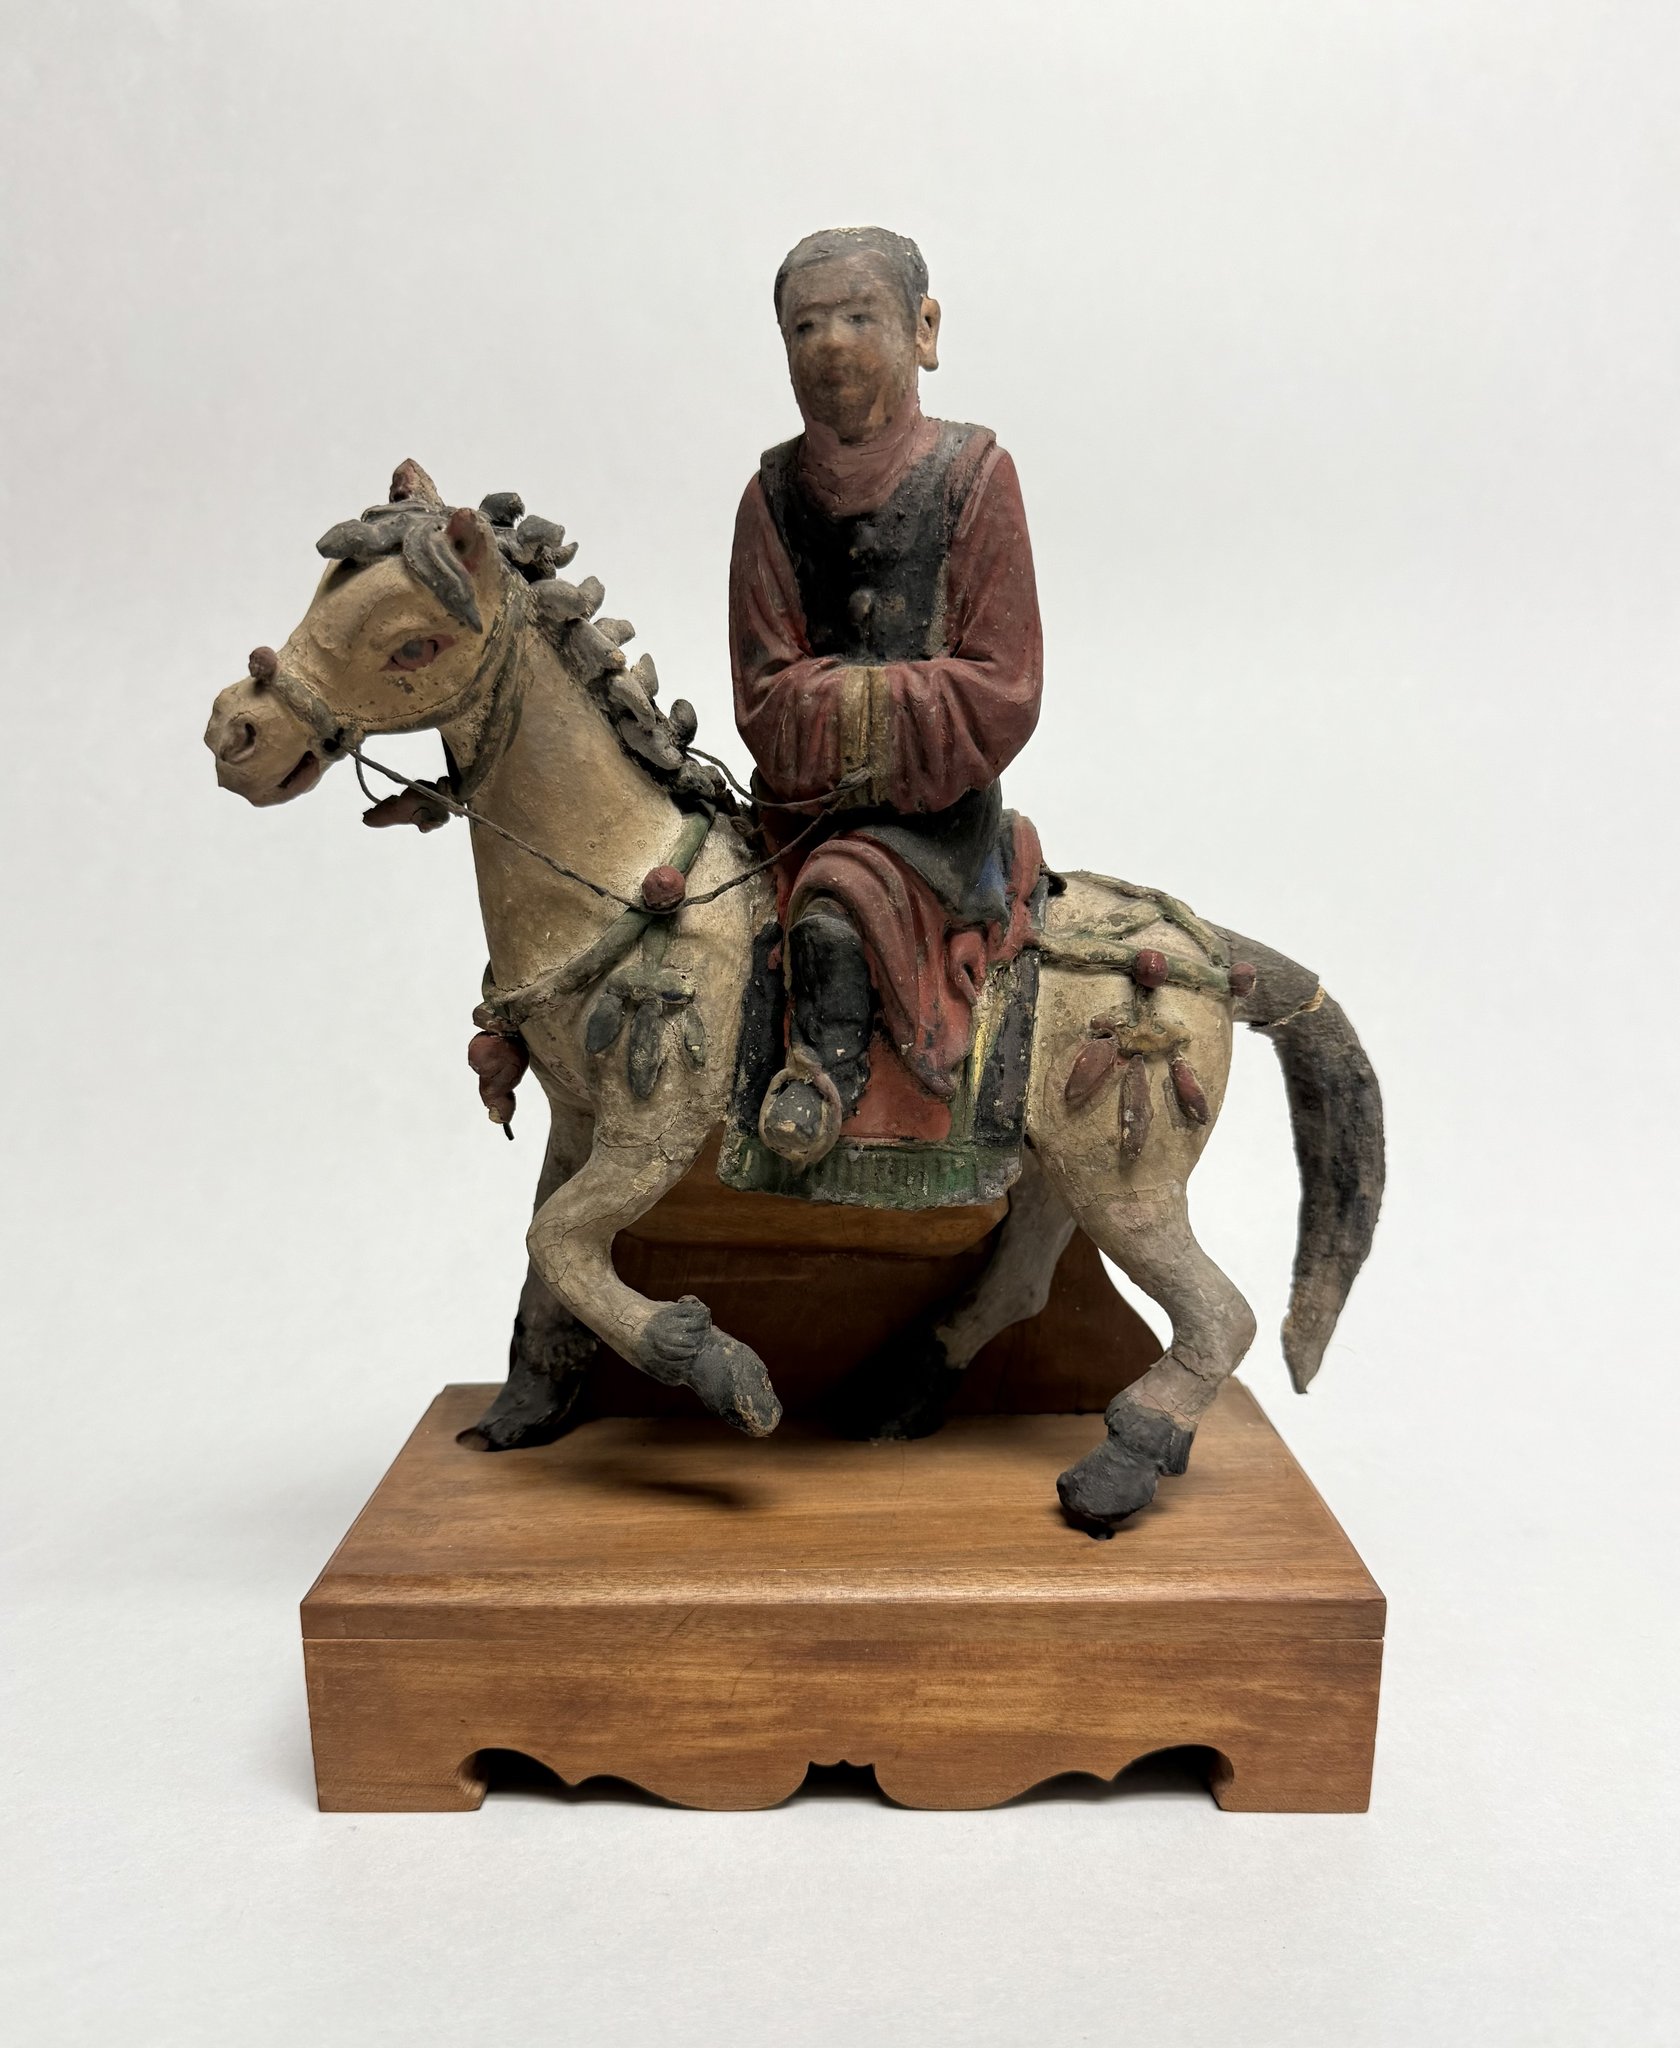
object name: figure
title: Horse and Rider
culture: chinese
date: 1368-1644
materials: clay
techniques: painting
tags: horses